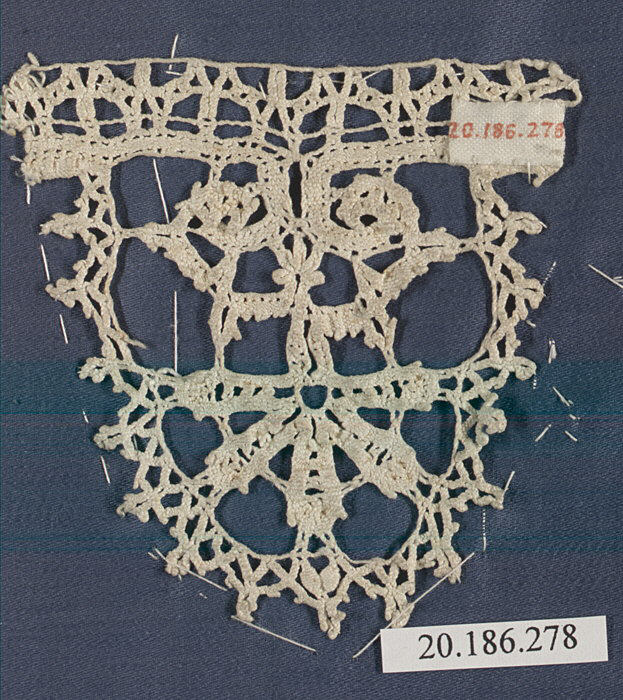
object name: fragment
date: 1601-1700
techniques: lace